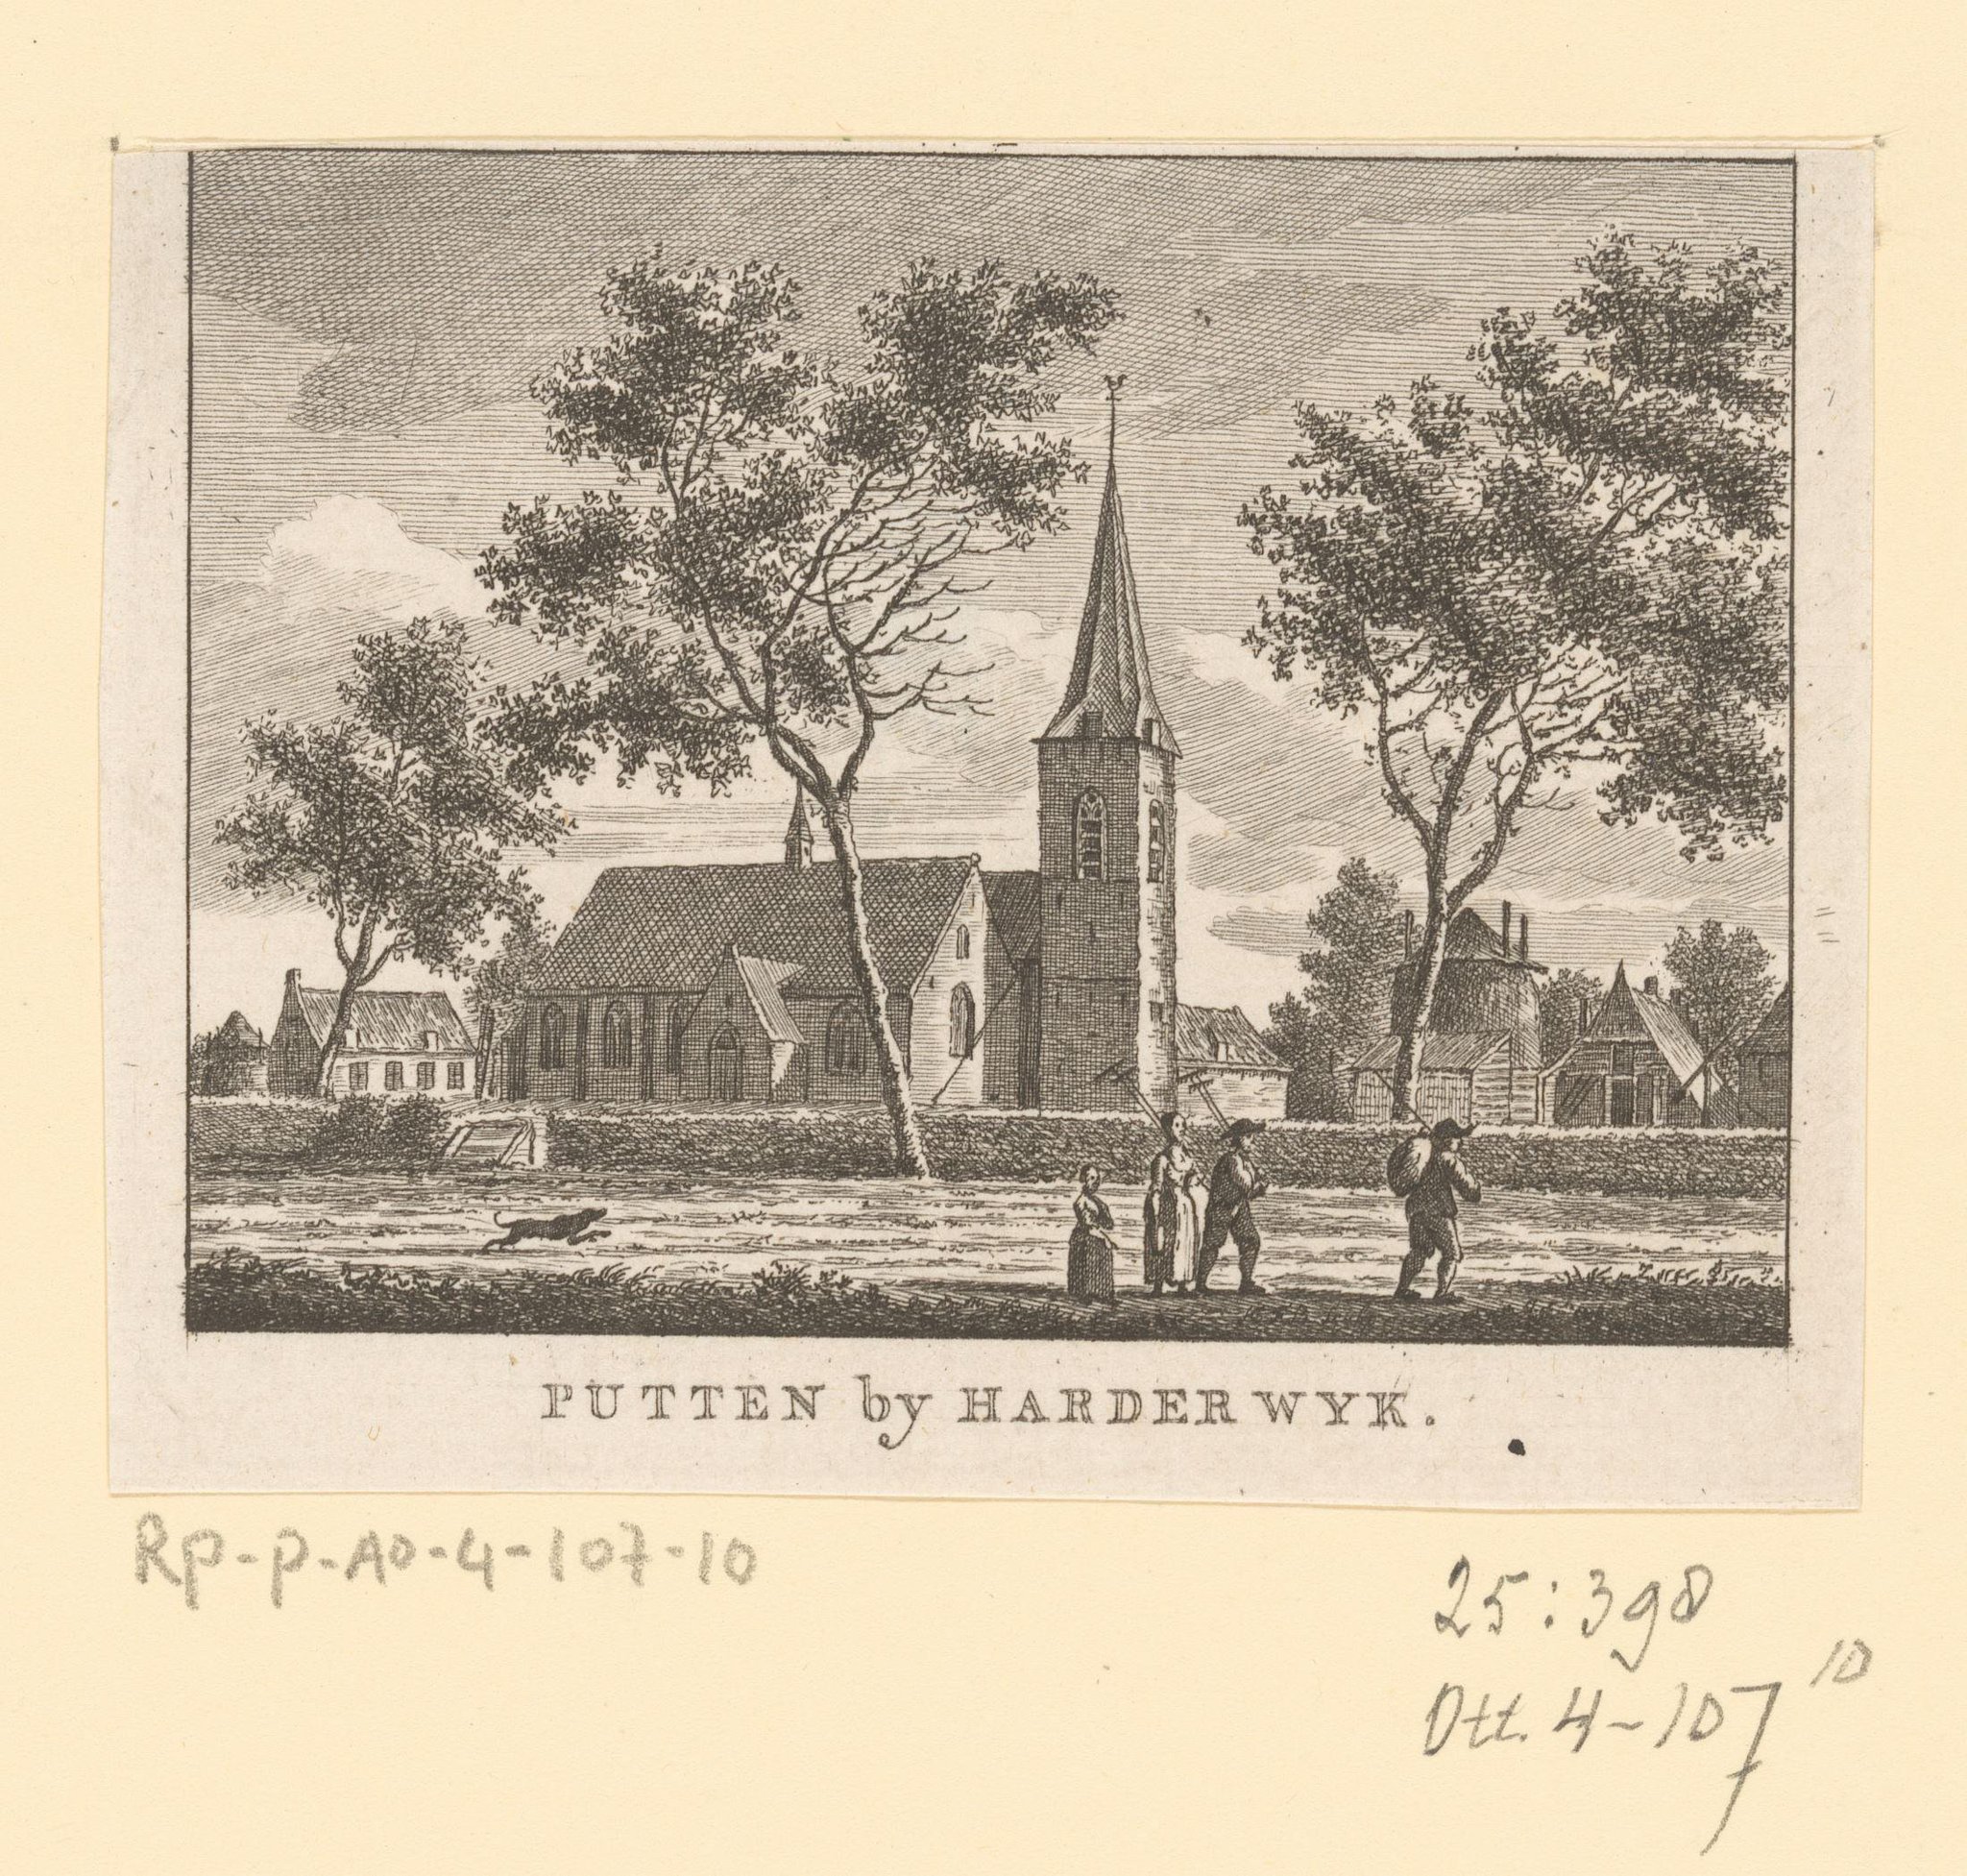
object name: print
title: Gezicht op Putten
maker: carel frederik bendorp (i)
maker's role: print maker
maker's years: 1736-1814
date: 1786-1792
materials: paper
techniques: etching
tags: prospect of village, silhouette of village, church (exterior)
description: Prent uit: Vaderlandsche gezichten, of afbeeldingen van den tegenwoordigen staat der Vereenigde Nederlanden (…). Amsterdam: Hendrik Gartman, Willem Vermandel en Jan Willem Smit, 1786-1792. Uitgegeven in afleveringen met ieder een eigen bifolium en inhoudsopgave. Alle prenten in deze publicatie zijn gegraveerd door Carel Frederik Bendorp (I) en, in de meeste gevallen, gebaseerd op tekeningen van Jan Bulthuis.